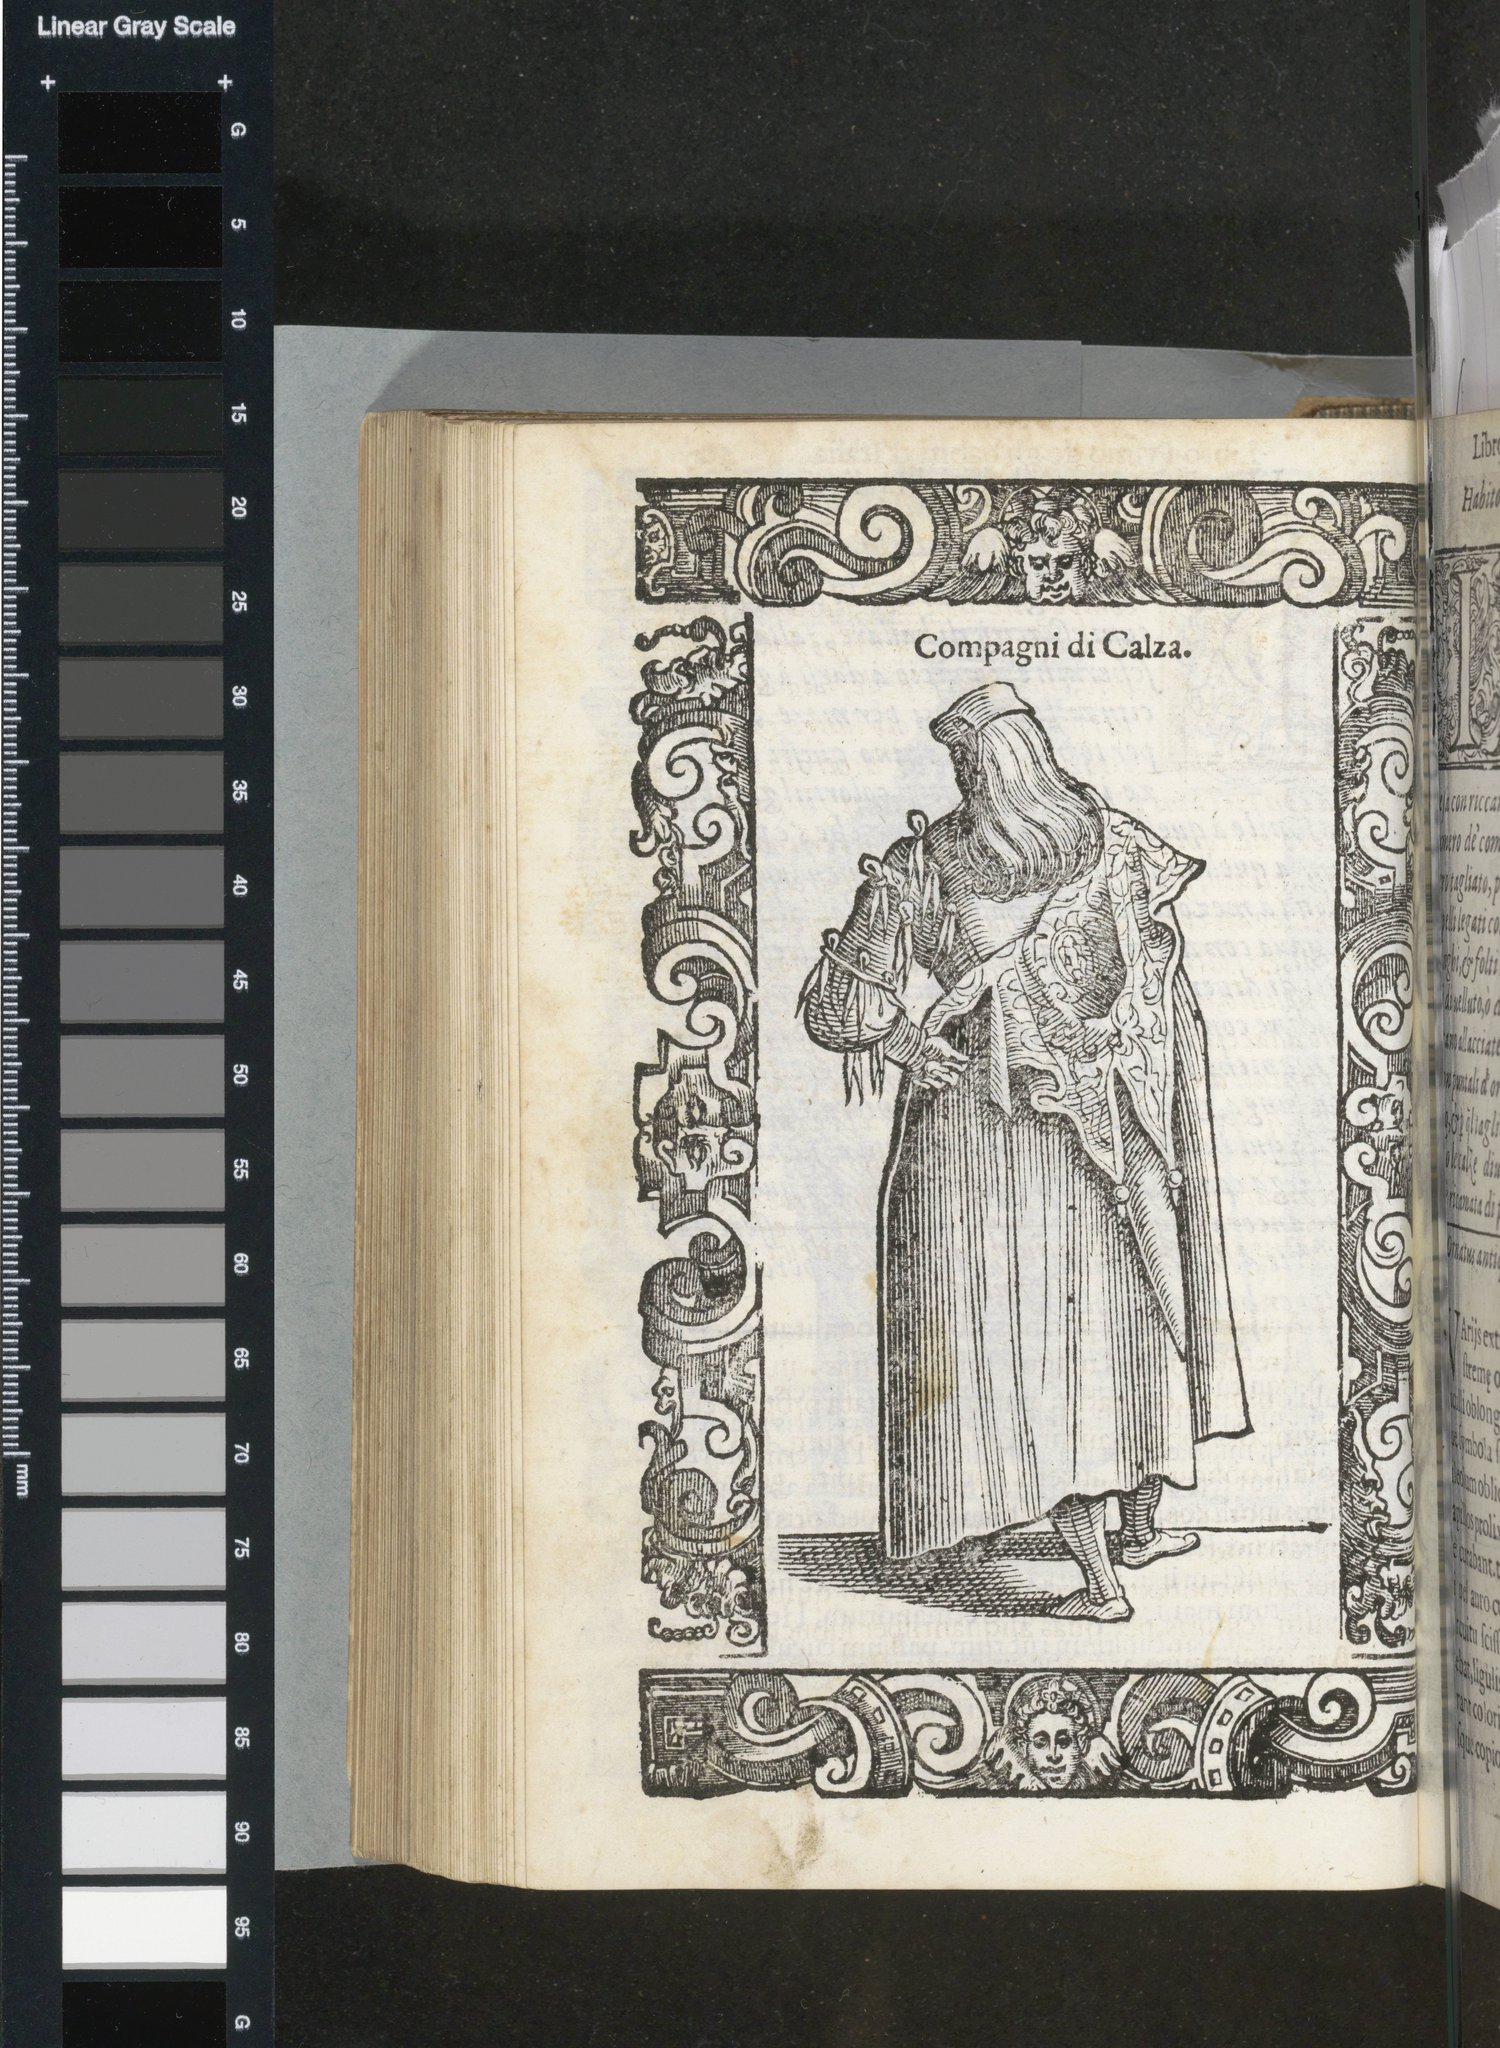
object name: costume print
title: Compagni di calza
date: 1598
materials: paper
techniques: woodcut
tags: fashion plates